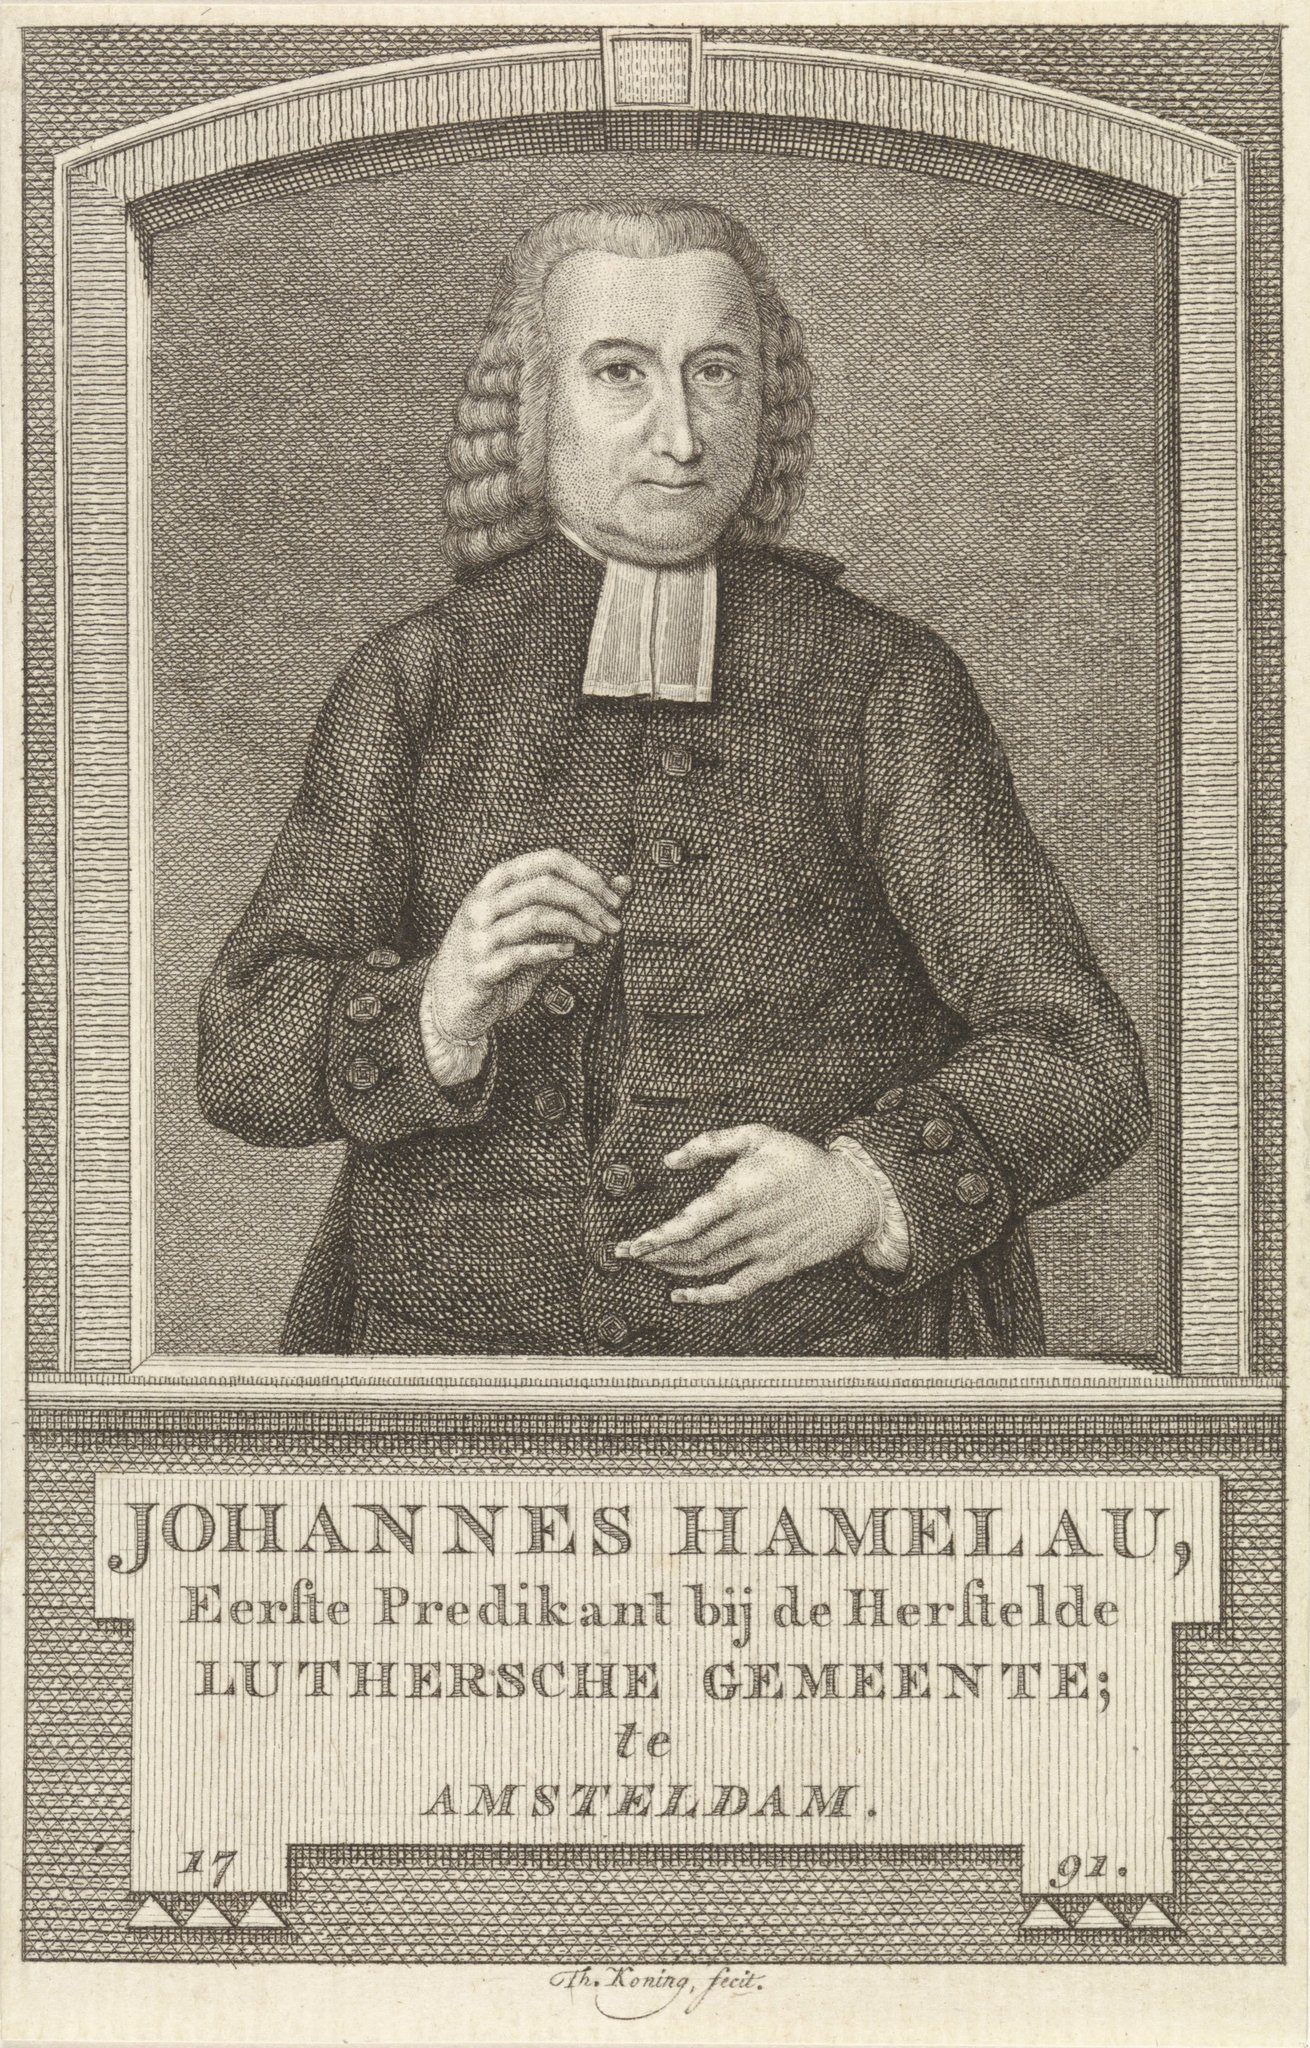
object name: print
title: Portret van Johannes Hamelau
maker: theodoor koning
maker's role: print maker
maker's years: 1748-1829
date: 1791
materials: paper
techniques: engraving, etching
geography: amsterdam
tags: predikant, johannes hamelau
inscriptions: collector's mark: Lugt 2228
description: Portret ten halven lijve van de predikant Johannes Hamelau in een venster. In de plaquette onder het venster staat een vijfregelig onderschrift.